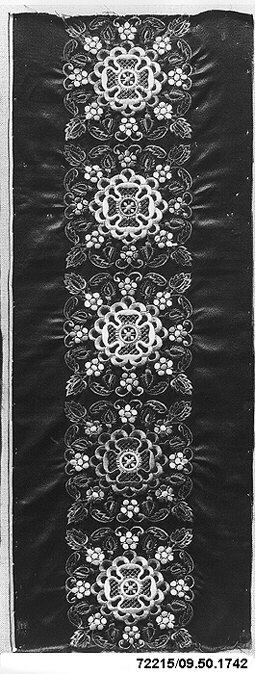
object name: fragment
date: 1801-1900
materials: silk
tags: flowers,leaves